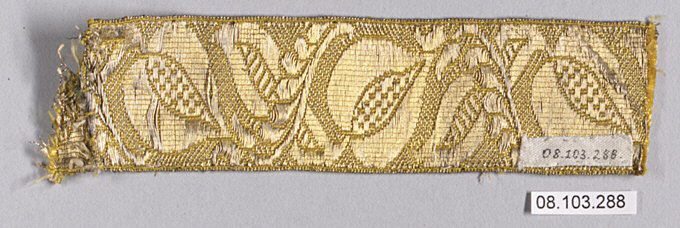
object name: galloon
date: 1601-1800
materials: metal thread